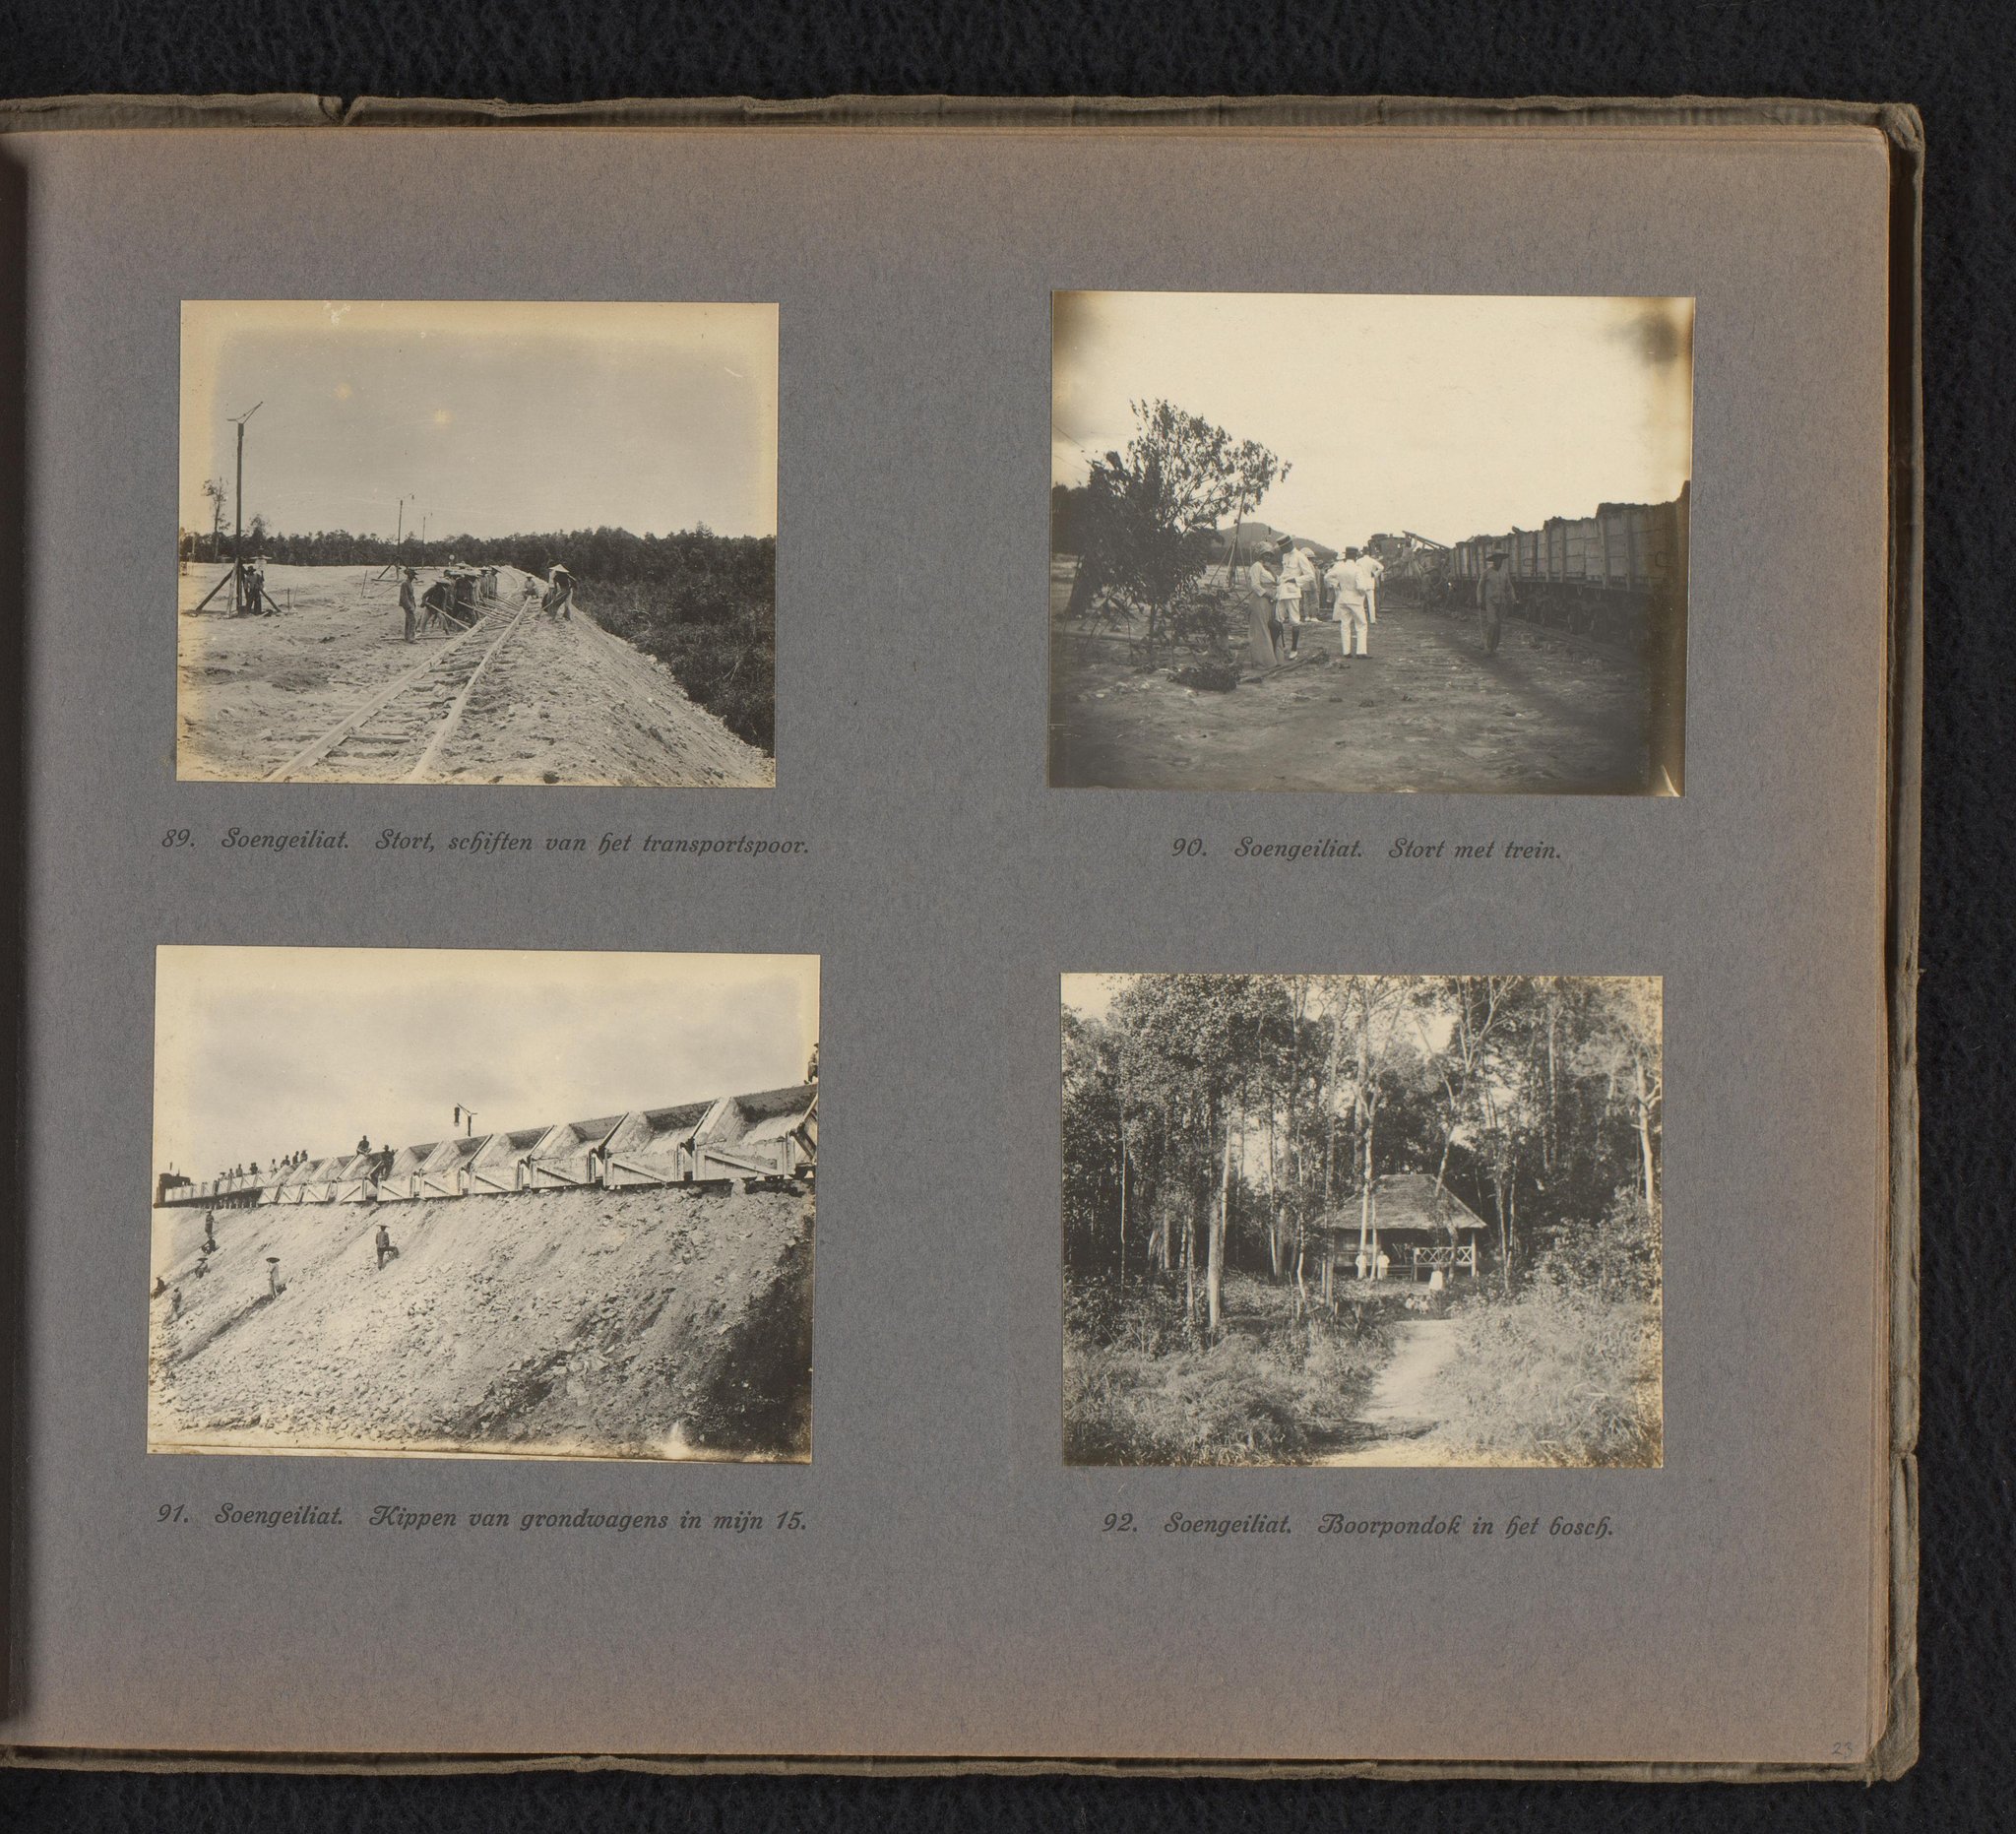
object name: photograph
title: Gezichten te Soengeiliat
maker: Anonymous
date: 1907-1919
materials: cardboard, photographic support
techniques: gelatin silver print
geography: bangka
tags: robert julius boers, colonial system, opencast mine; strip mining, minerals and metals: tin, landscapes in tropical and sub-tropical regions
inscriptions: inscription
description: Albumblad met vier foto's genummerd 89-92 van verschillende gezichten bij de tinmijnen te Soengeiliat op Banka: afvoer en stort van afgegraven grond en een boorpondok in het bos. Onderdeel van het Banka-Album met foto's over het eiland Banka en de tinwinning door het staatsbedrijf de Banka-tinwinning in de periode ca. 1907-1919.